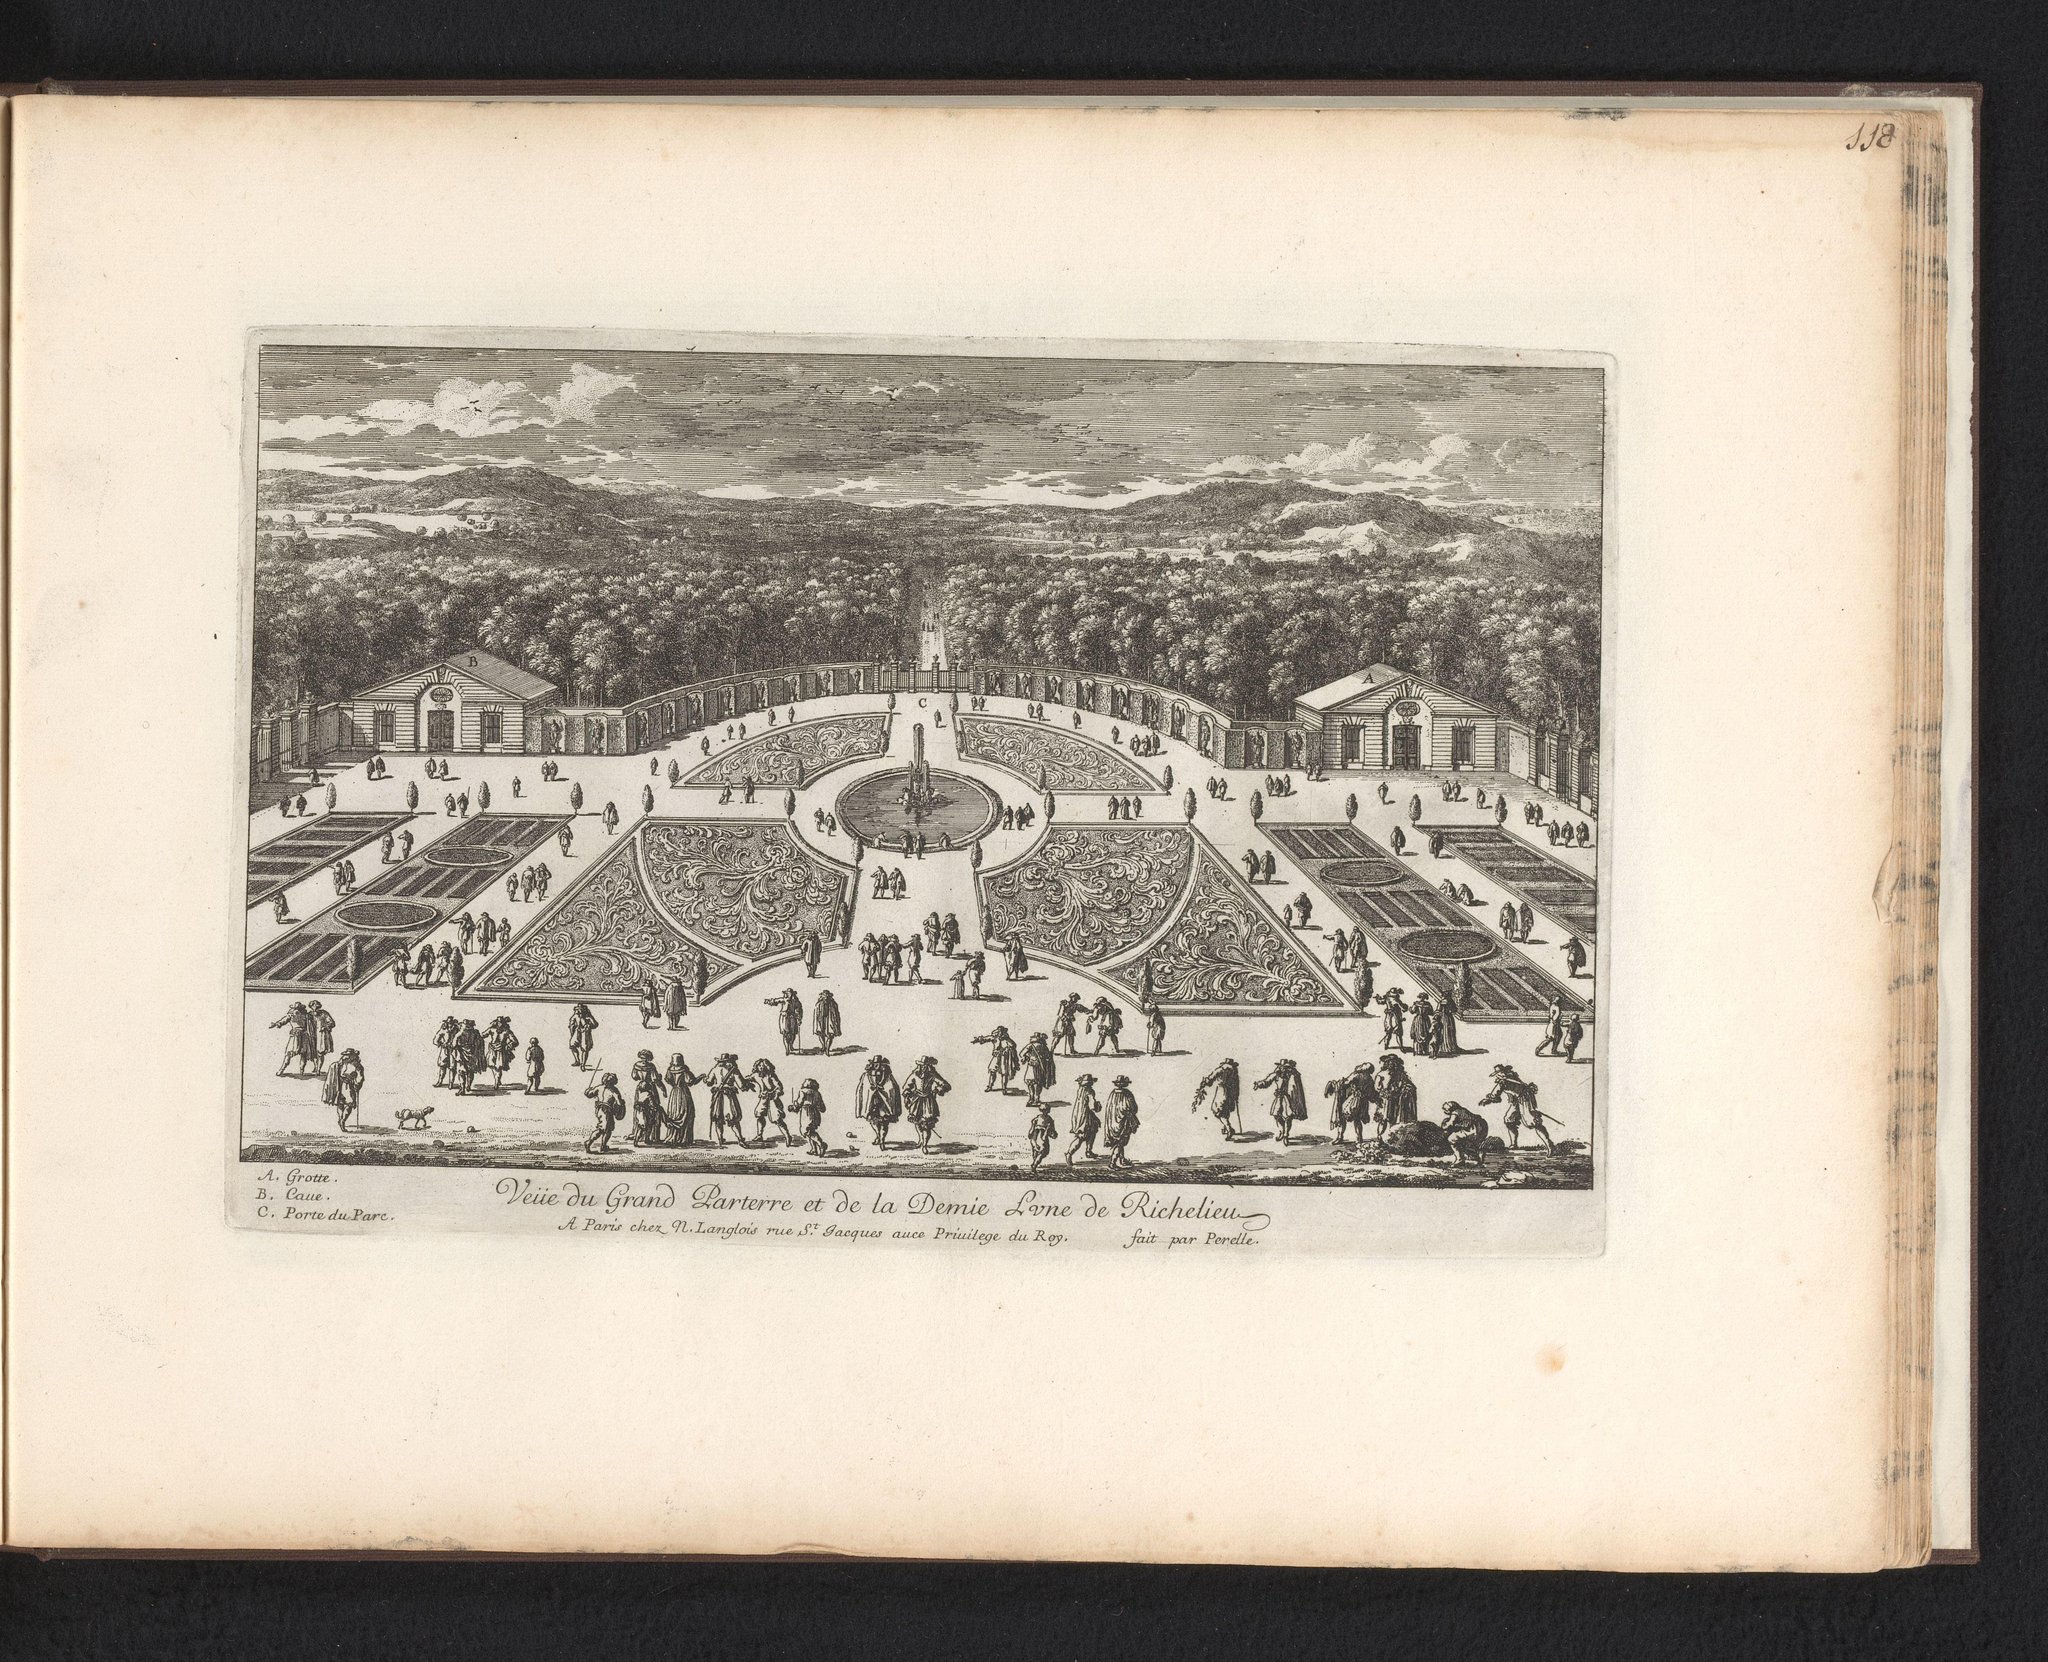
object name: album leaf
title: Veüe du Grand Parterre et de la Demie Lune de Richelieu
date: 1650-1695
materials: paper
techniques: etching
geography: paris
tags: french or architectonic garden; formal garden, landscape with tower or castle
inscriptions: collector's mark: Lugt 2228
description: Prenten met het signatuur 'Perelle' kunnen zowel door vader Gabriel als door zonen Nicolas en Adam gemaakt zijn. De uitgevers vader en zoon Nicolas Langlois worden allebei vermeld als N. Langlois op hetzelfde adres.